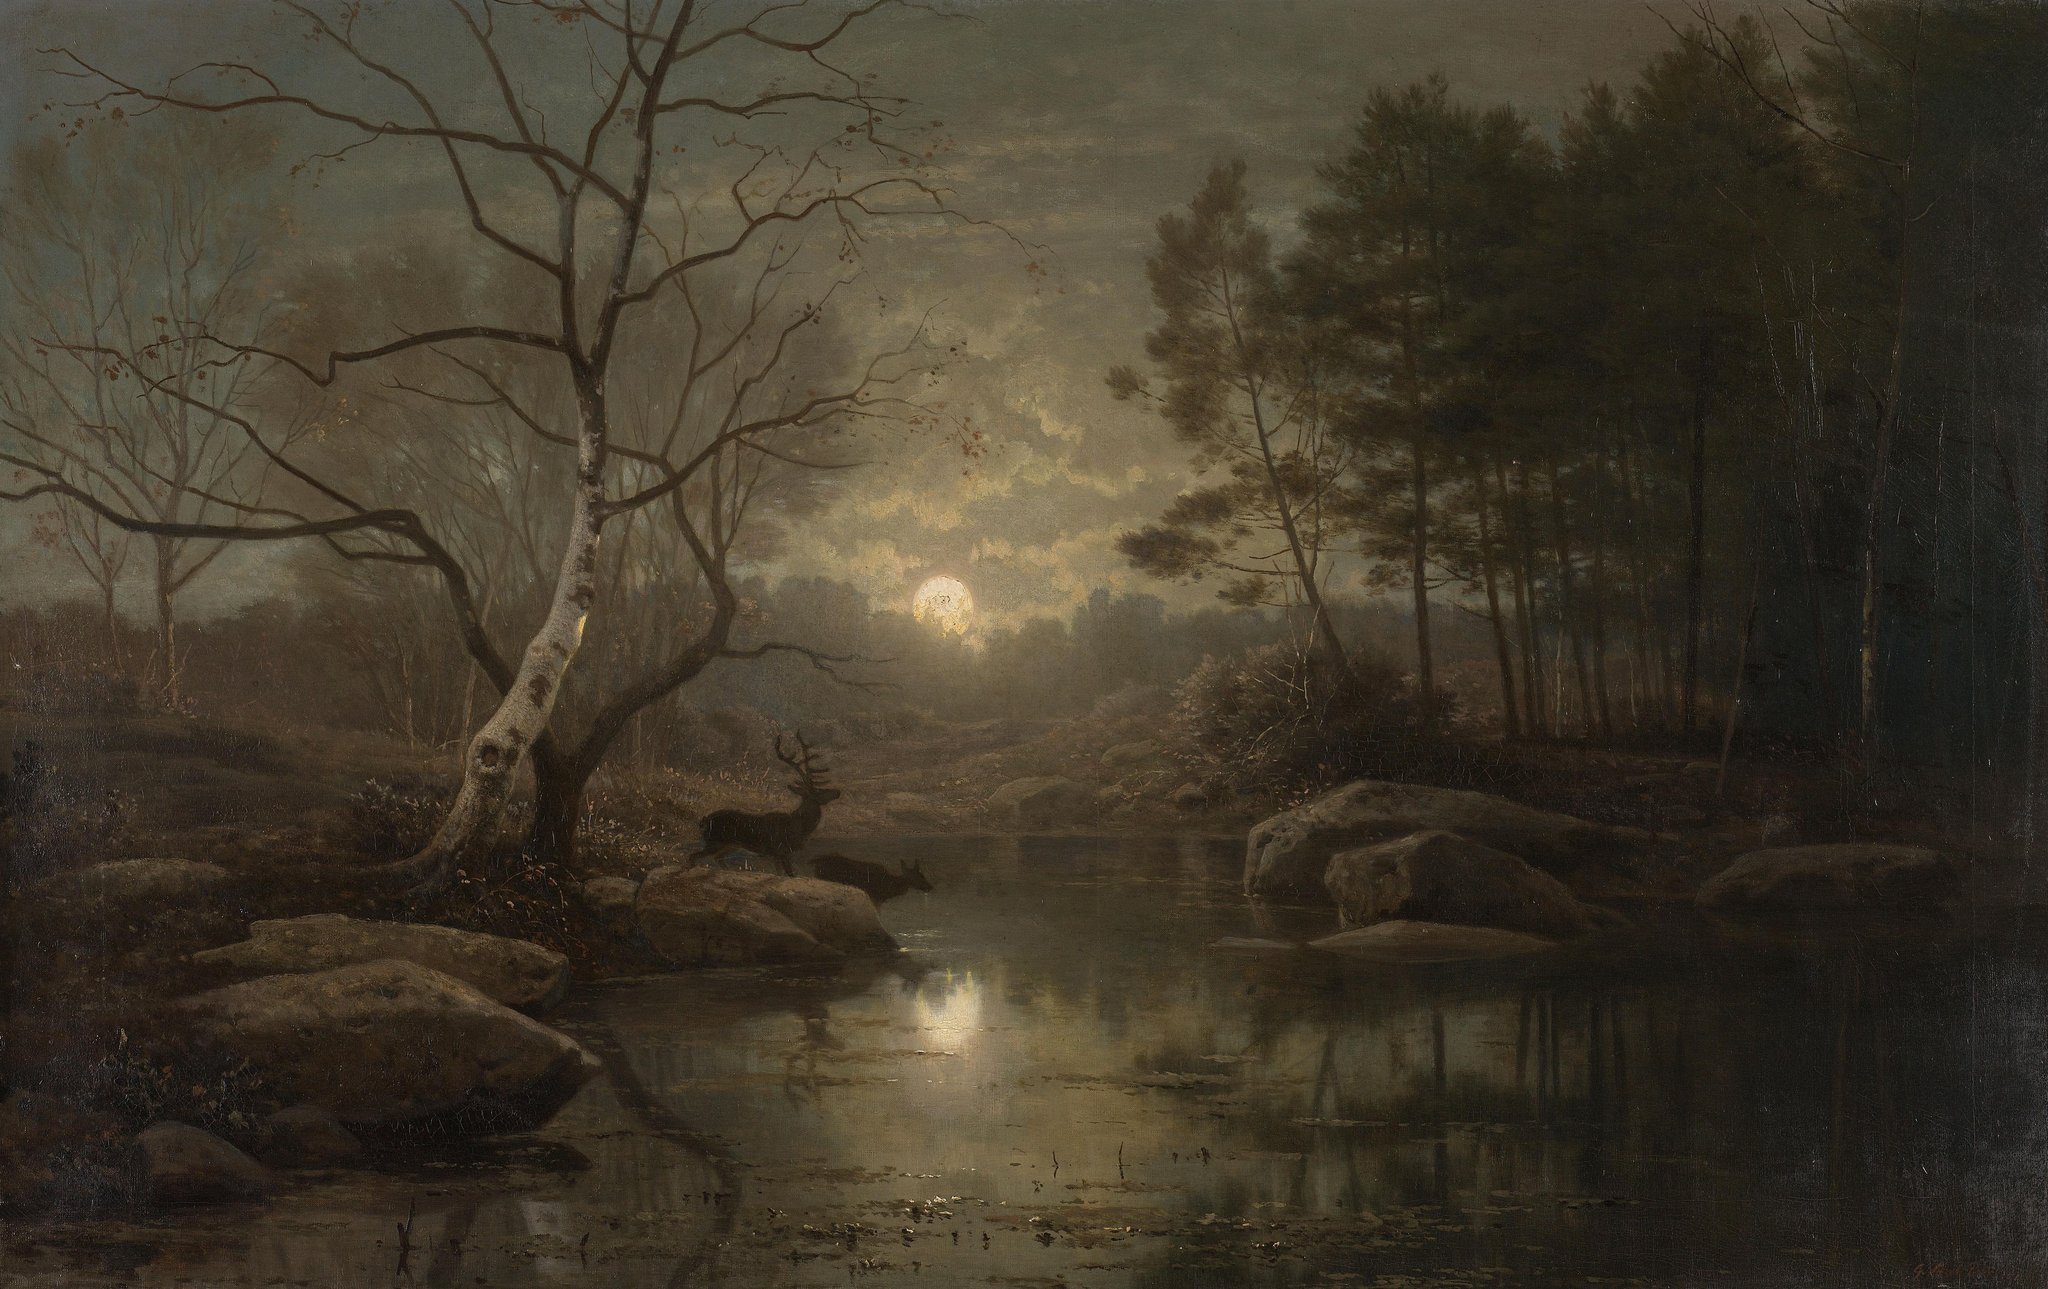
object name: painting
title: Forest Landscape in the Moonlight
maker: georg eduard otto saal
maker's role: painter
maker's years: 1817-1870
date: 1861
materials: canvas, oil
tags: river, moonlight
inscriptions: signature and date: ‘G. Saal Paris 1861’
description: Boslandschap bij maanlicht. Twee herten staan bij de oever van een meertje.